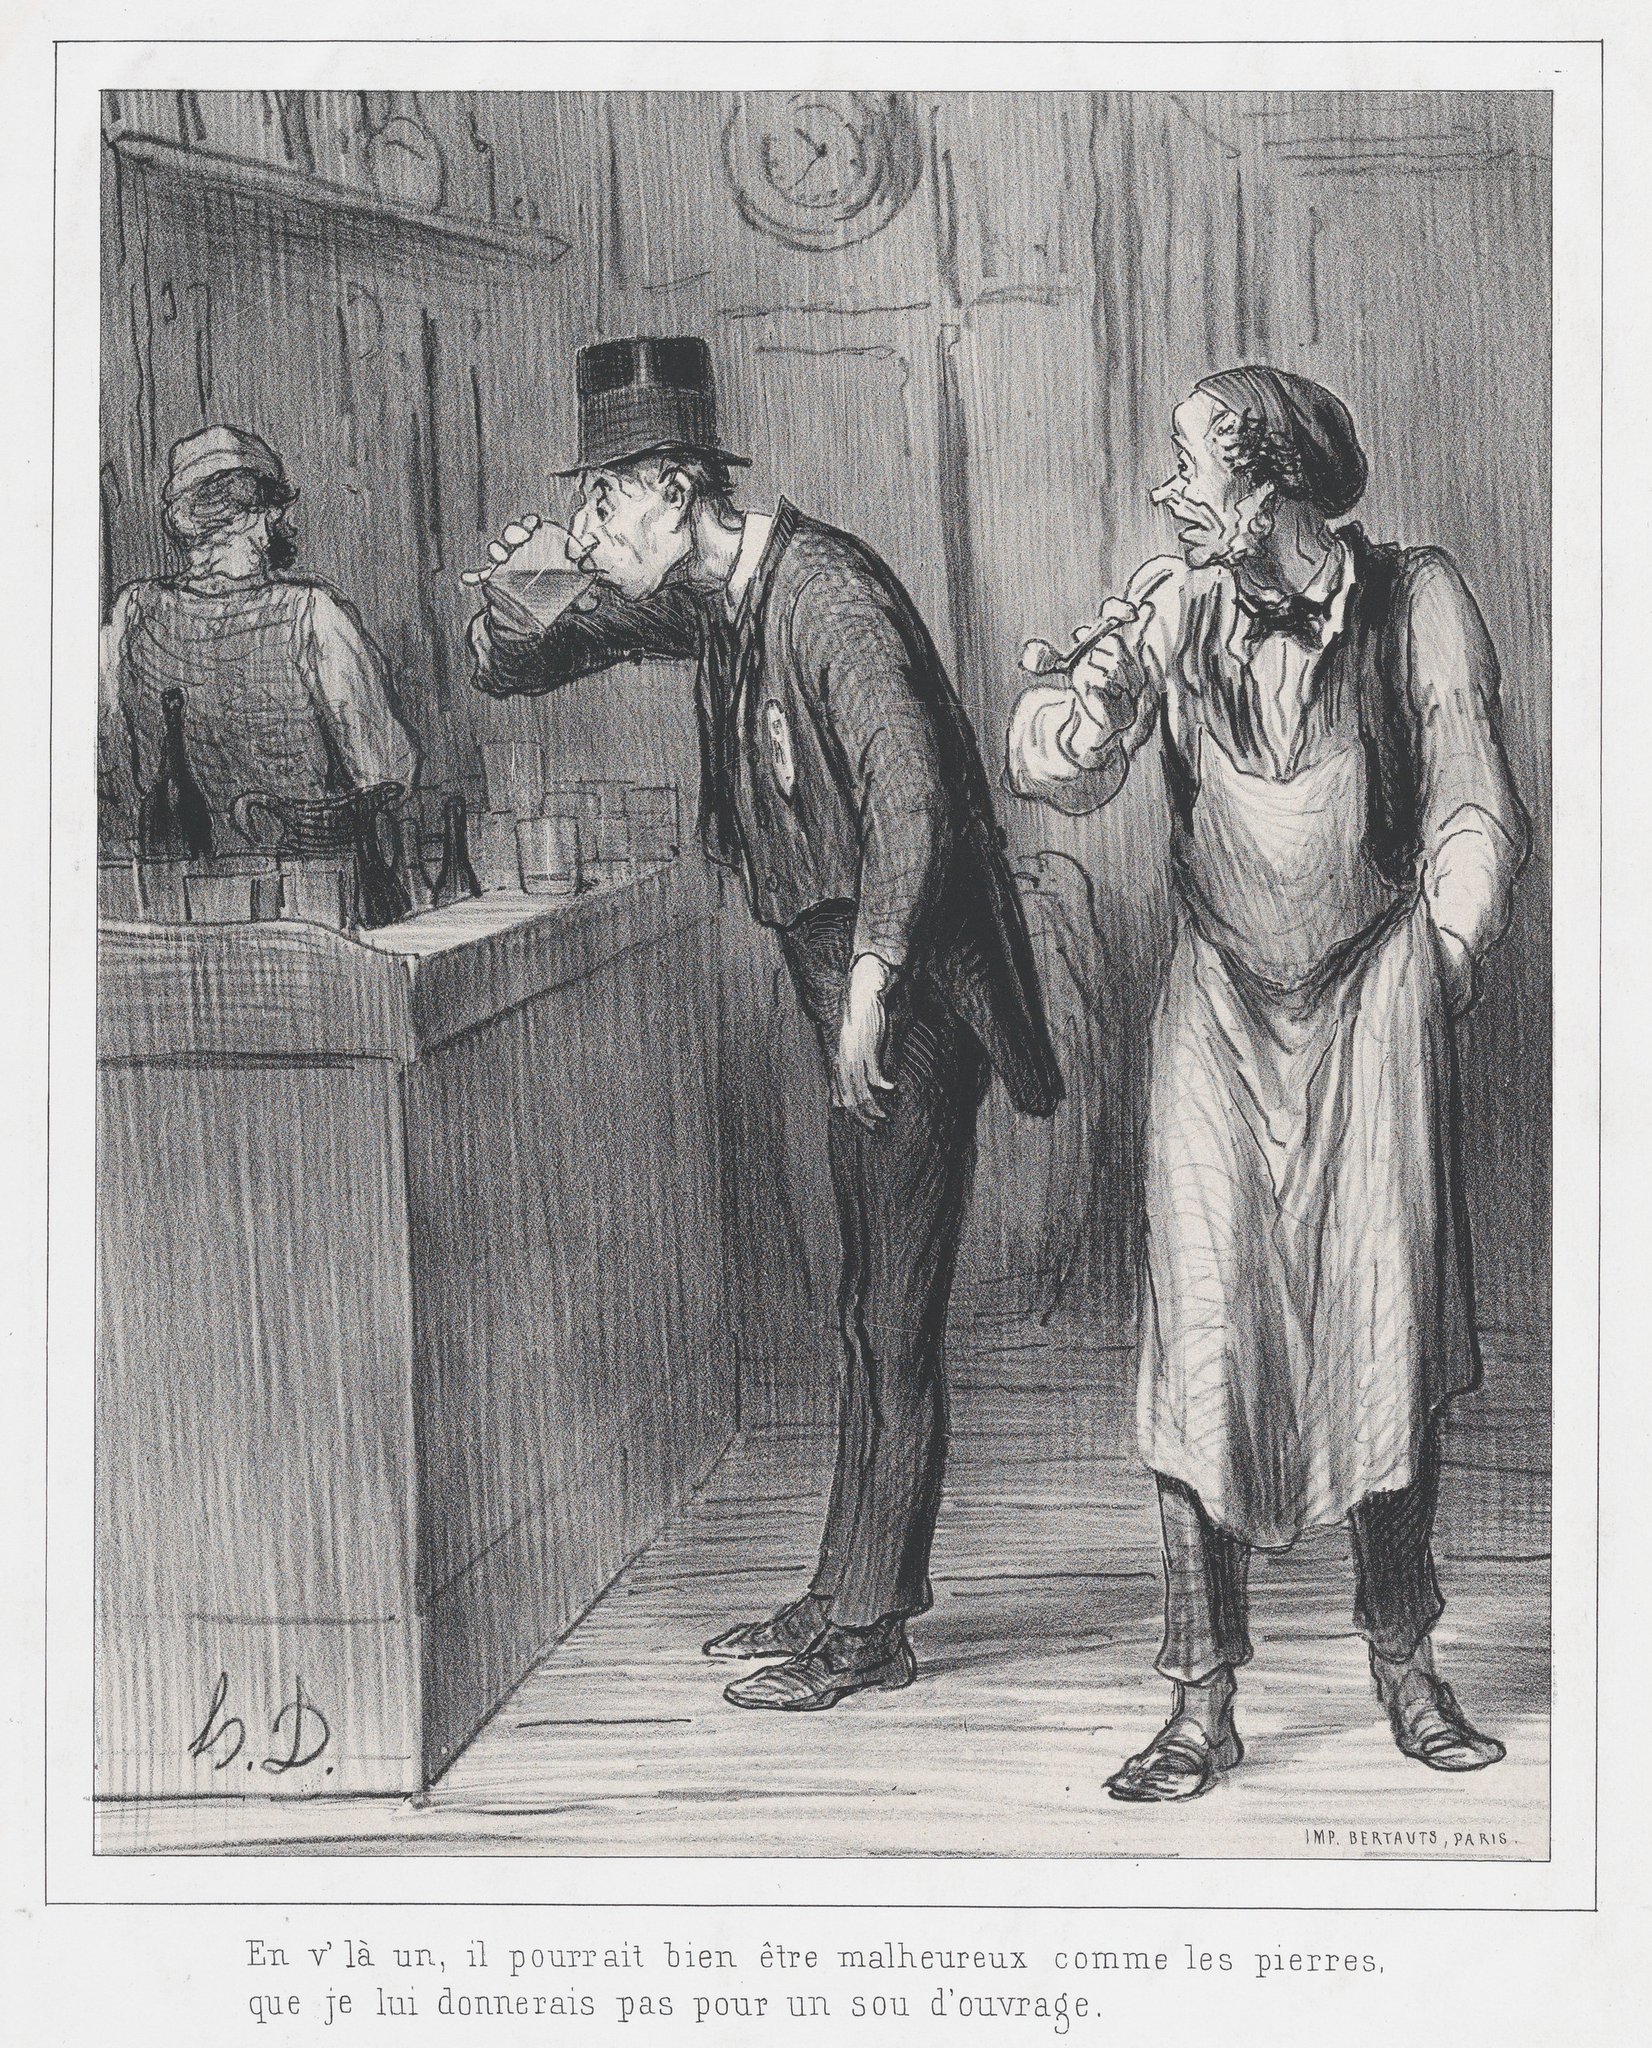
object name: print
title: This one may look as unhappy as a rock, before I would give him a job, published in "Le Boulevard"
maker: honoré daumier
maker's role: artist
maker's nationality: french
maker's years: 1808-1879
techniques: lithograph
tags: satire,men,women,drinking